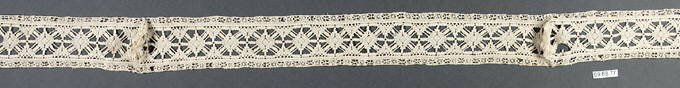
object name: insertion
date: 1601-1700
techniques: lace